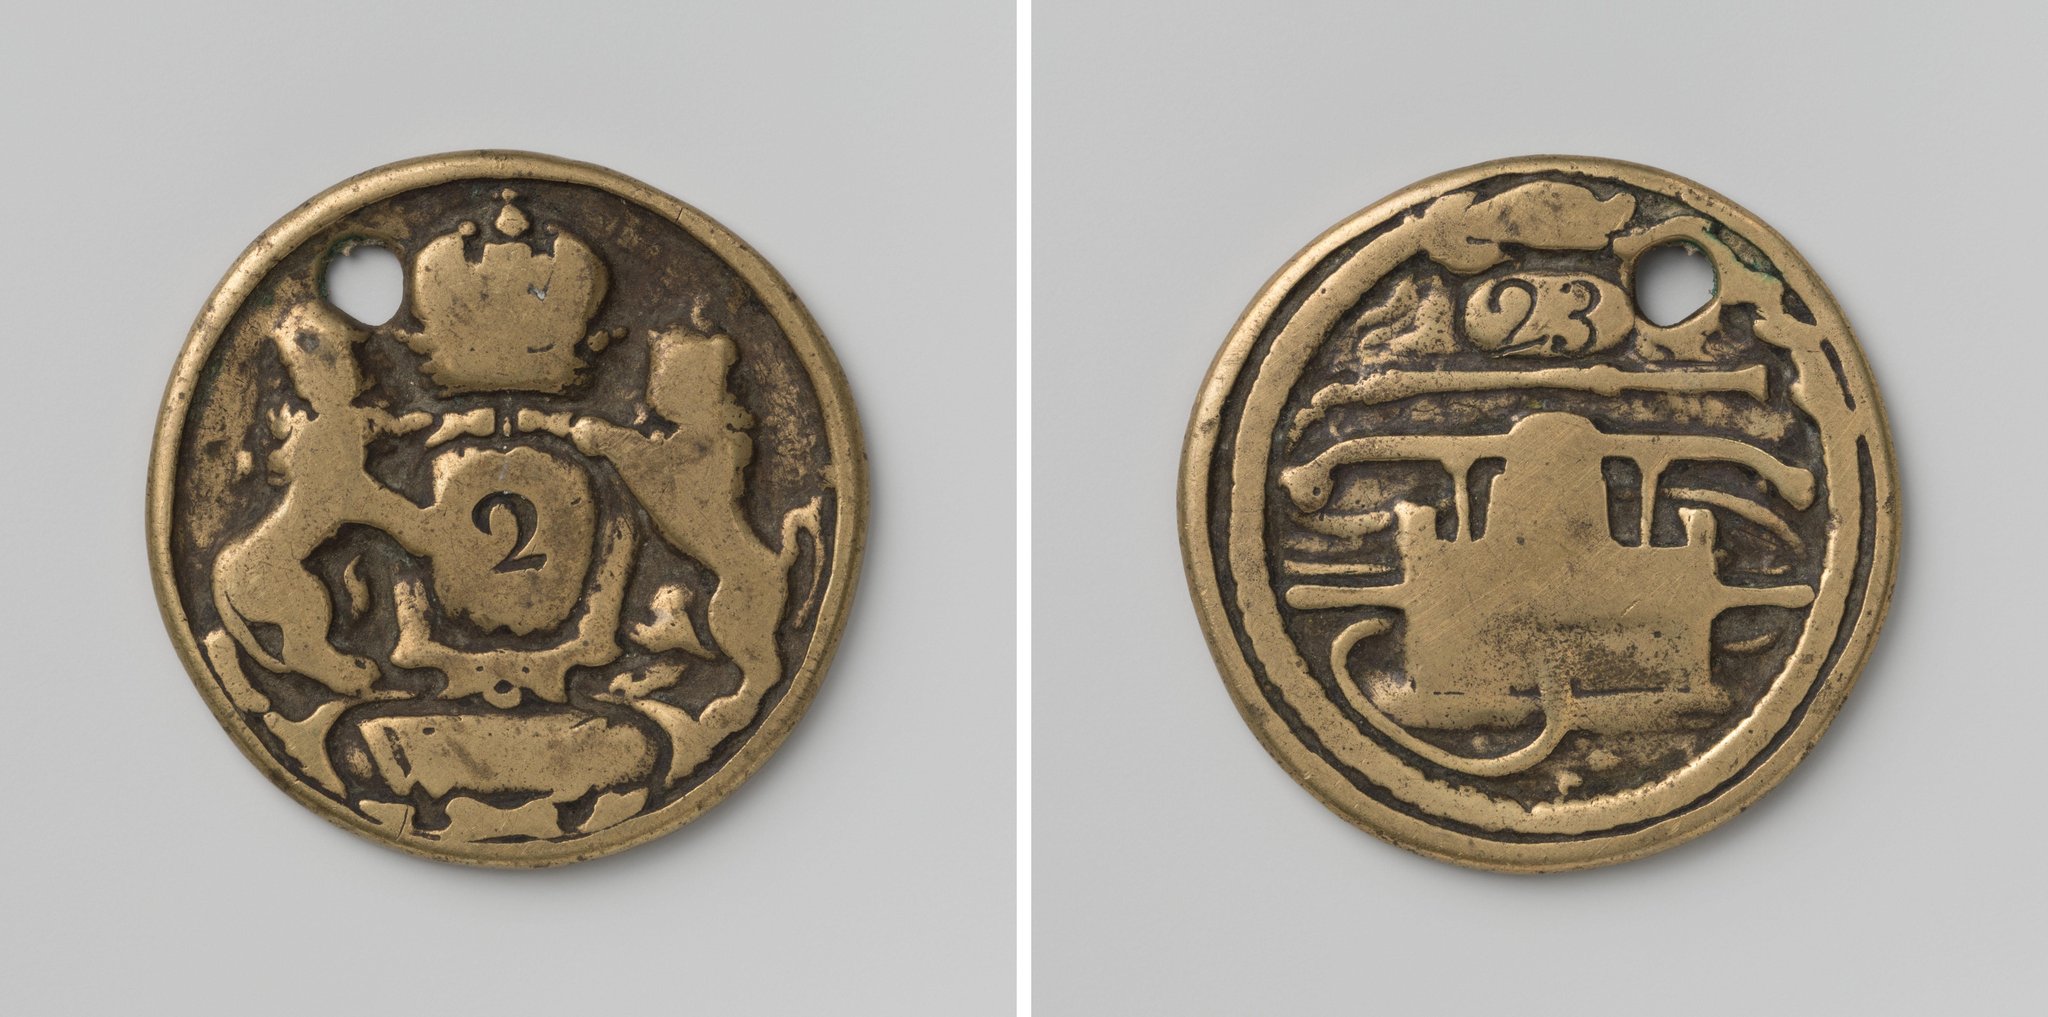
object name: fire engine medal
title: Amsterdam, brandspuitpenning met no. 2 en no. 23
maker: Anonymous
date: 1680-1800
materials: brass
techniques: casting, engraving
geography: amsterdam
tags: amsterdam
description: Messing penning met gat erin. Voorzijde: gekroond wapenschild, geflankeerd door twee leeuwen boven cartouche met opschrift, waarvan alleen letter W nog leesbaar is; over wapenschild heen gestempeld: cijfer 2. Keerzijde: brandspuit onder cartouche met no. 23 binnen slangerond